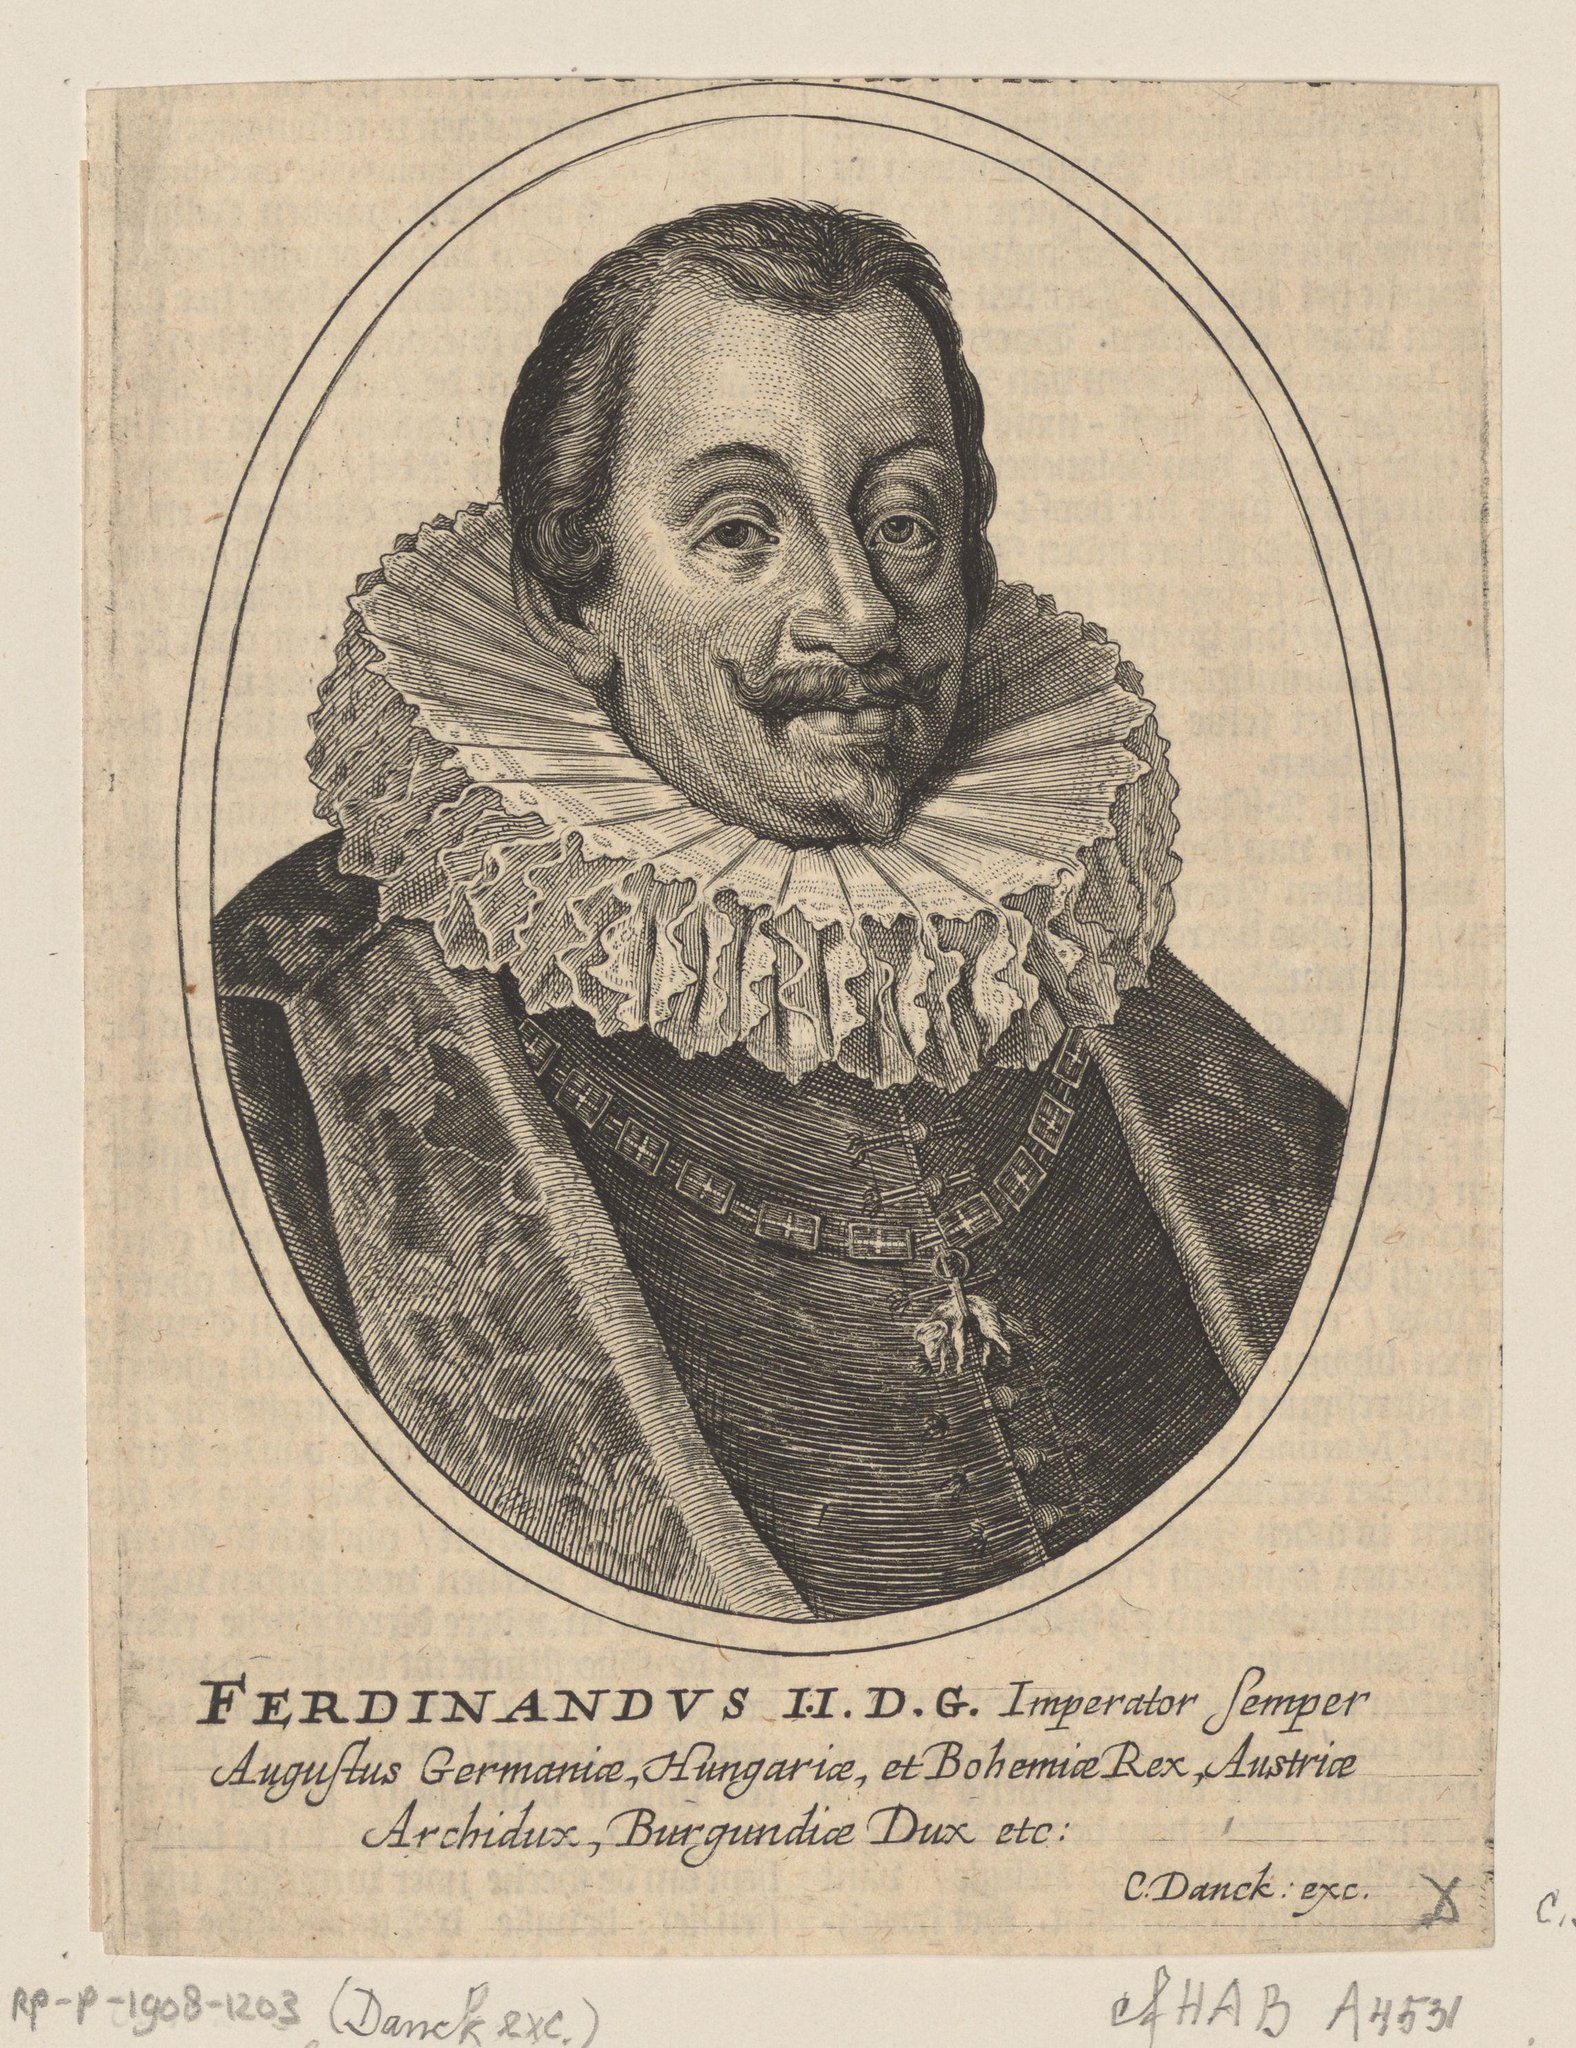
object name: print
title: Portret van keizer Ferdinand II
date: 1642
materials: paper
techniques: engraving, letterpress printing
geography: amsterdam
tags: vienna, ferdinand ii (duits keizer), historical persons, knighthood order of the golden fleece, emperor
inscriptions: collector's mark: Lugt 2228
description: Prent uit: Historis oft waerachtich verhael van den gantschen toestant van oorlooge, soo die ghevoert is in Duytschlandt (...). Amsterdam: Cornelis Danckerts, 1642, p. 4.